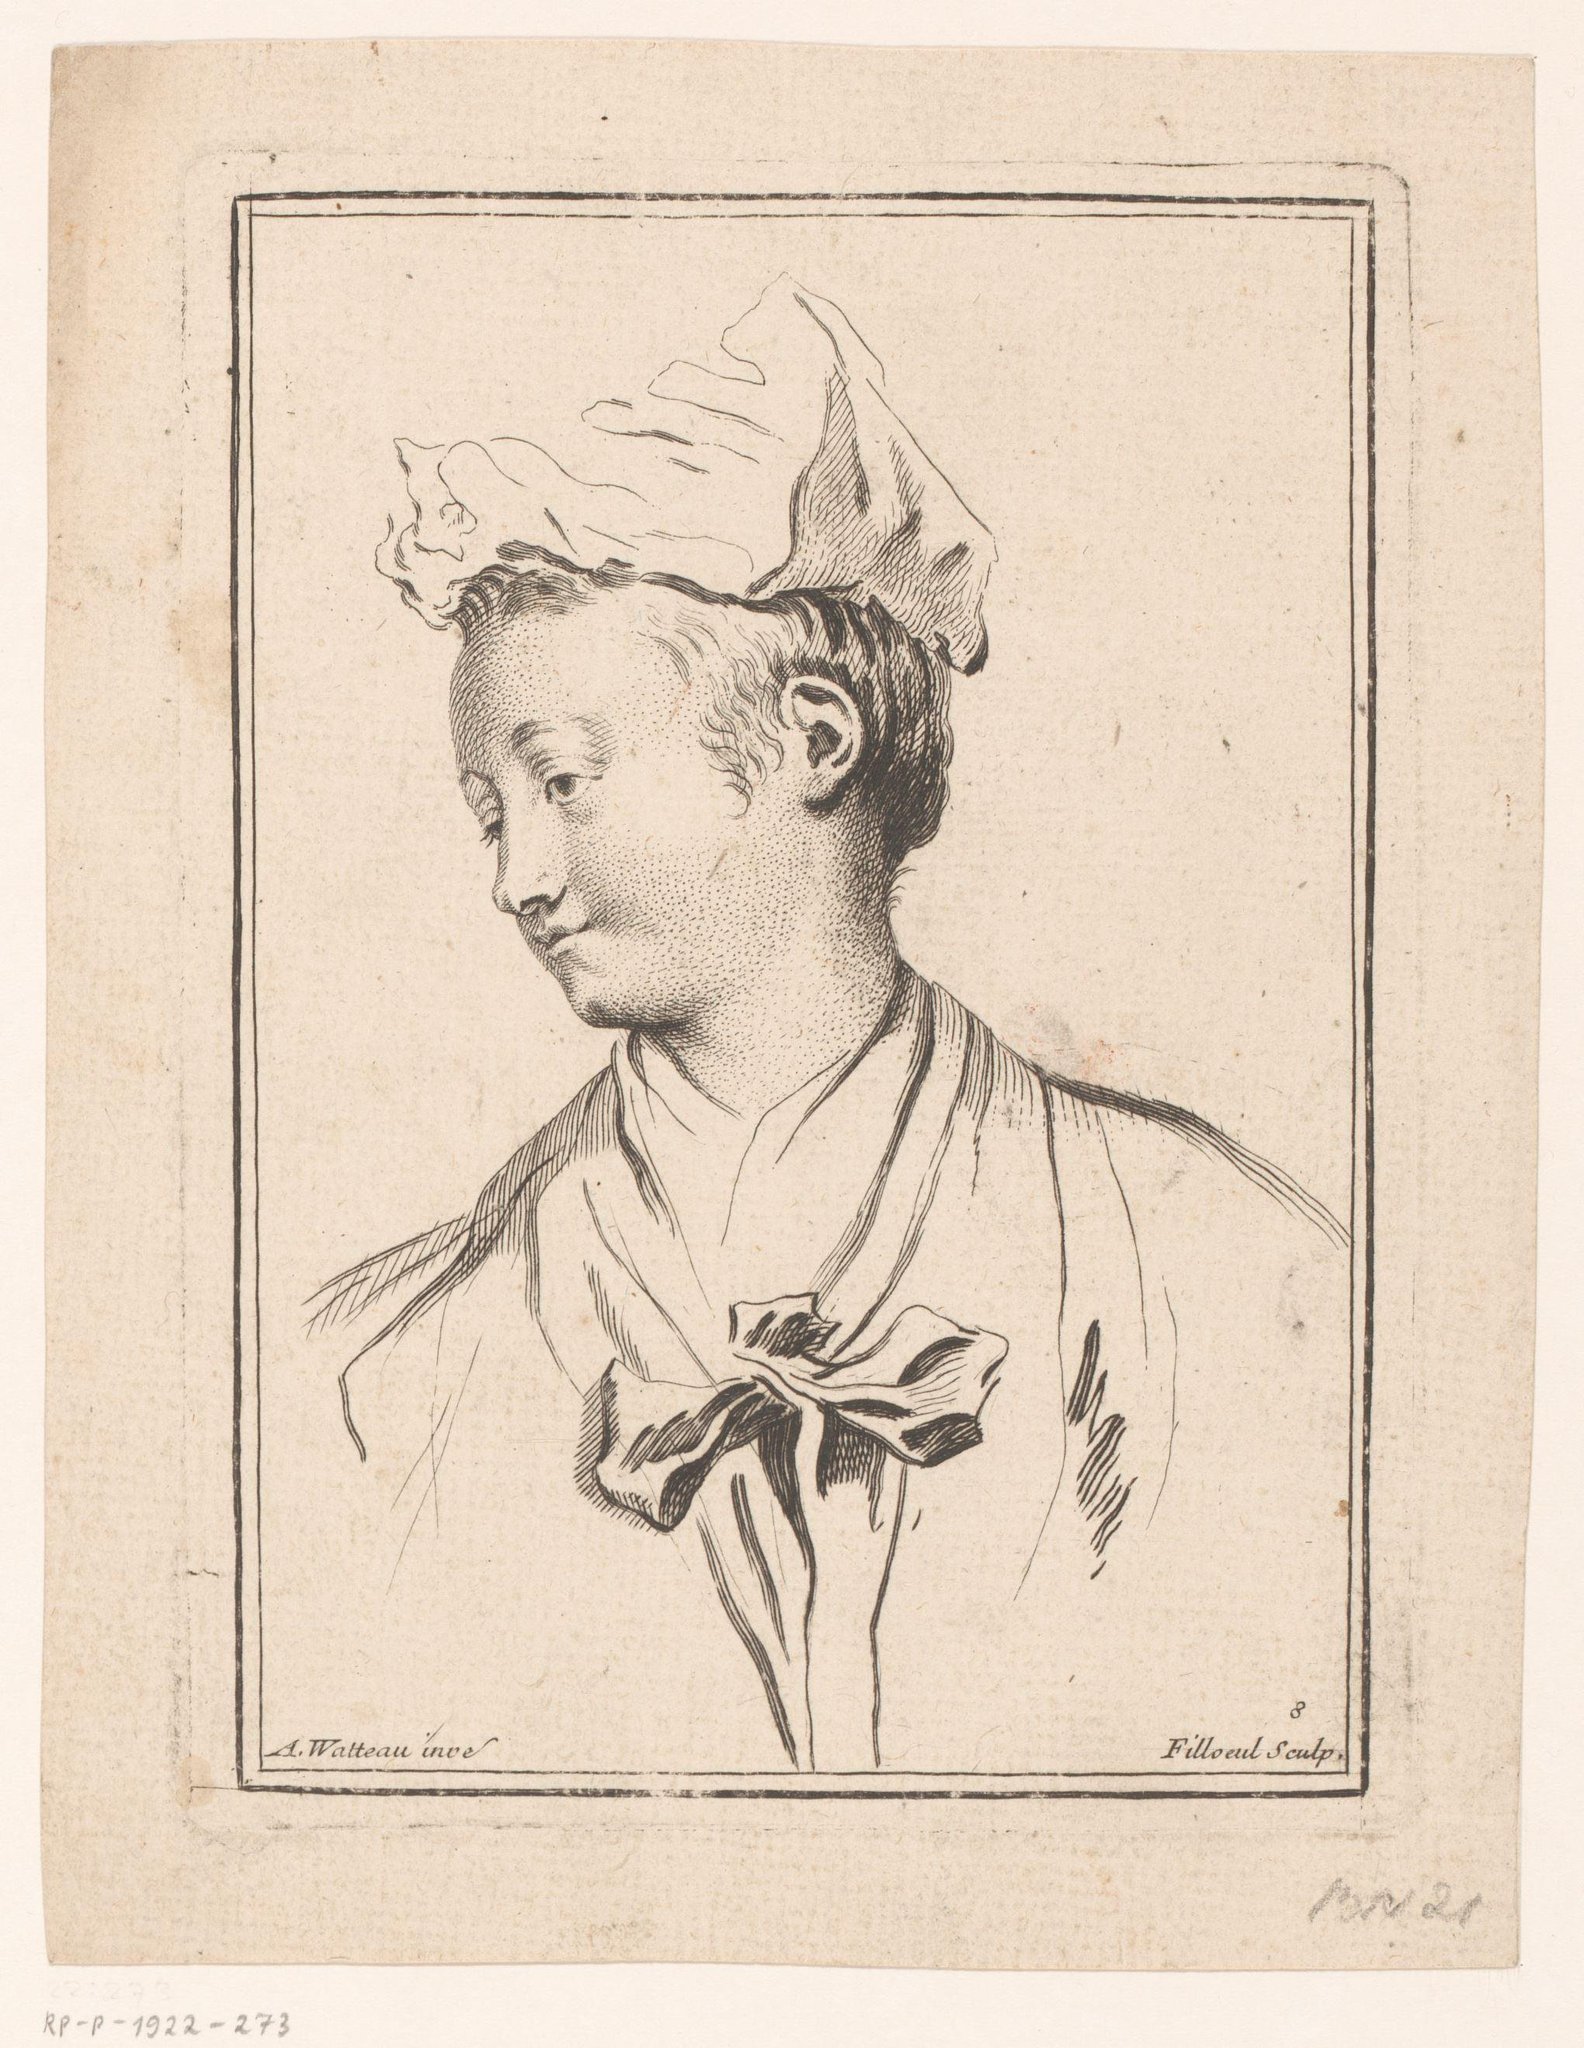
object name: print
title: Portret van een onbekende jonge vrouw, gezicht naar links gekeerd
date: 1734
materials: paper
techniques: engraving, etching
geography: france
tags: youth, adolescent, head-gear: cap (+ women's clothes)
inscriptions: collector's mark: Lugt 2233